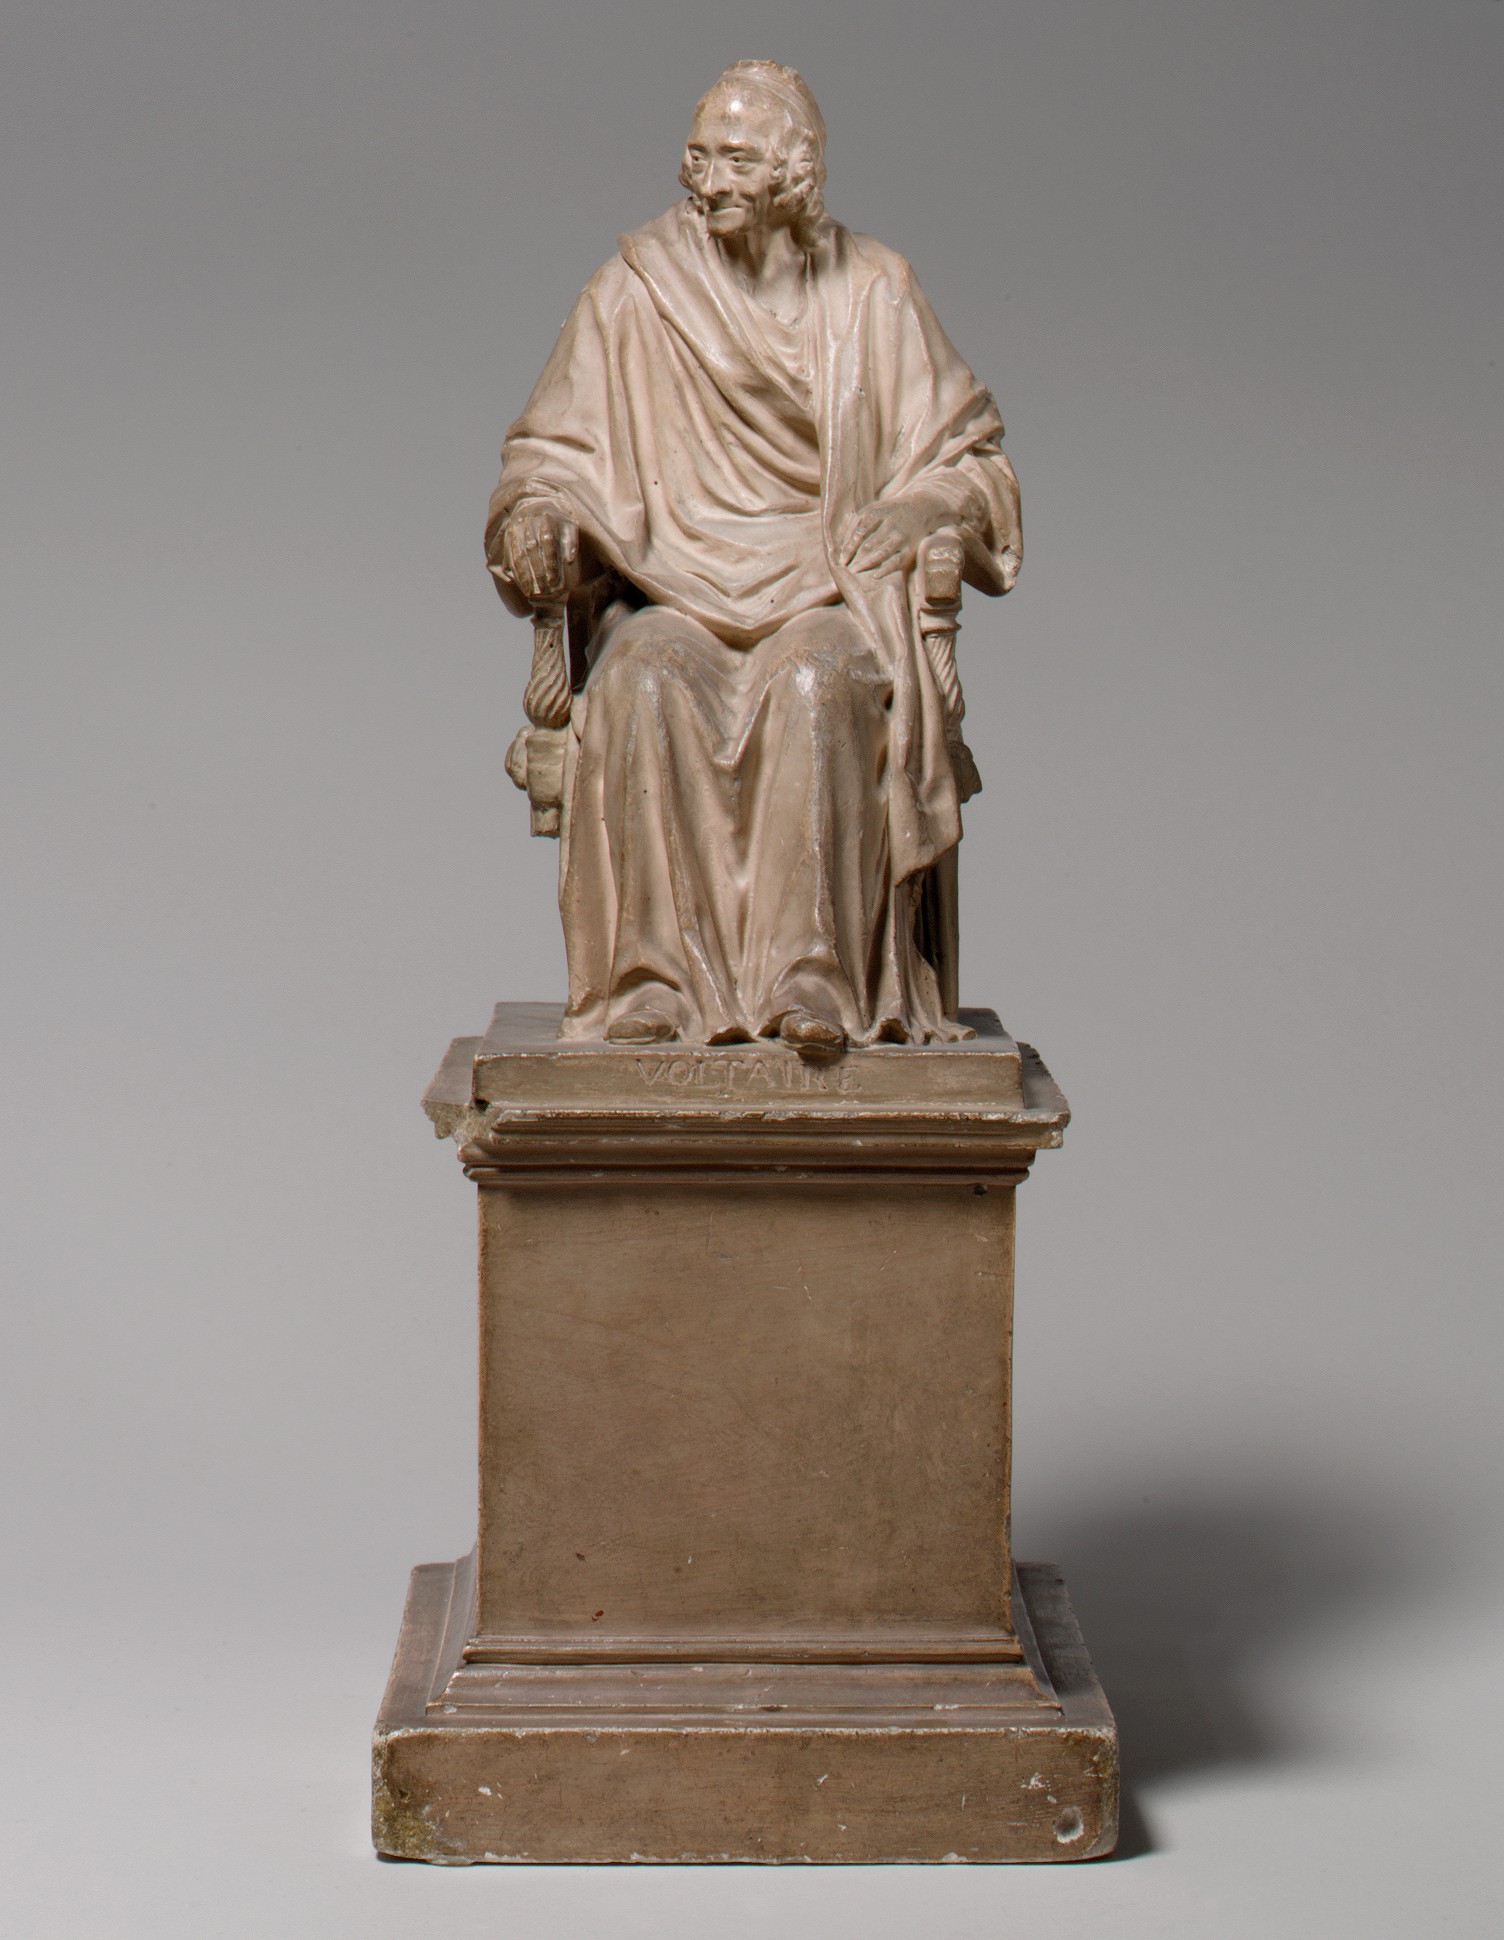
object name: statuette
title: Seated Voltaire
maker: jean antoine houdon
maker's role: artist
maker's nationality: french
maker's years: 1741-1828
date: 1778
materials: plaster, terracotta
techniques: tinting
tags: men,portraits,authors